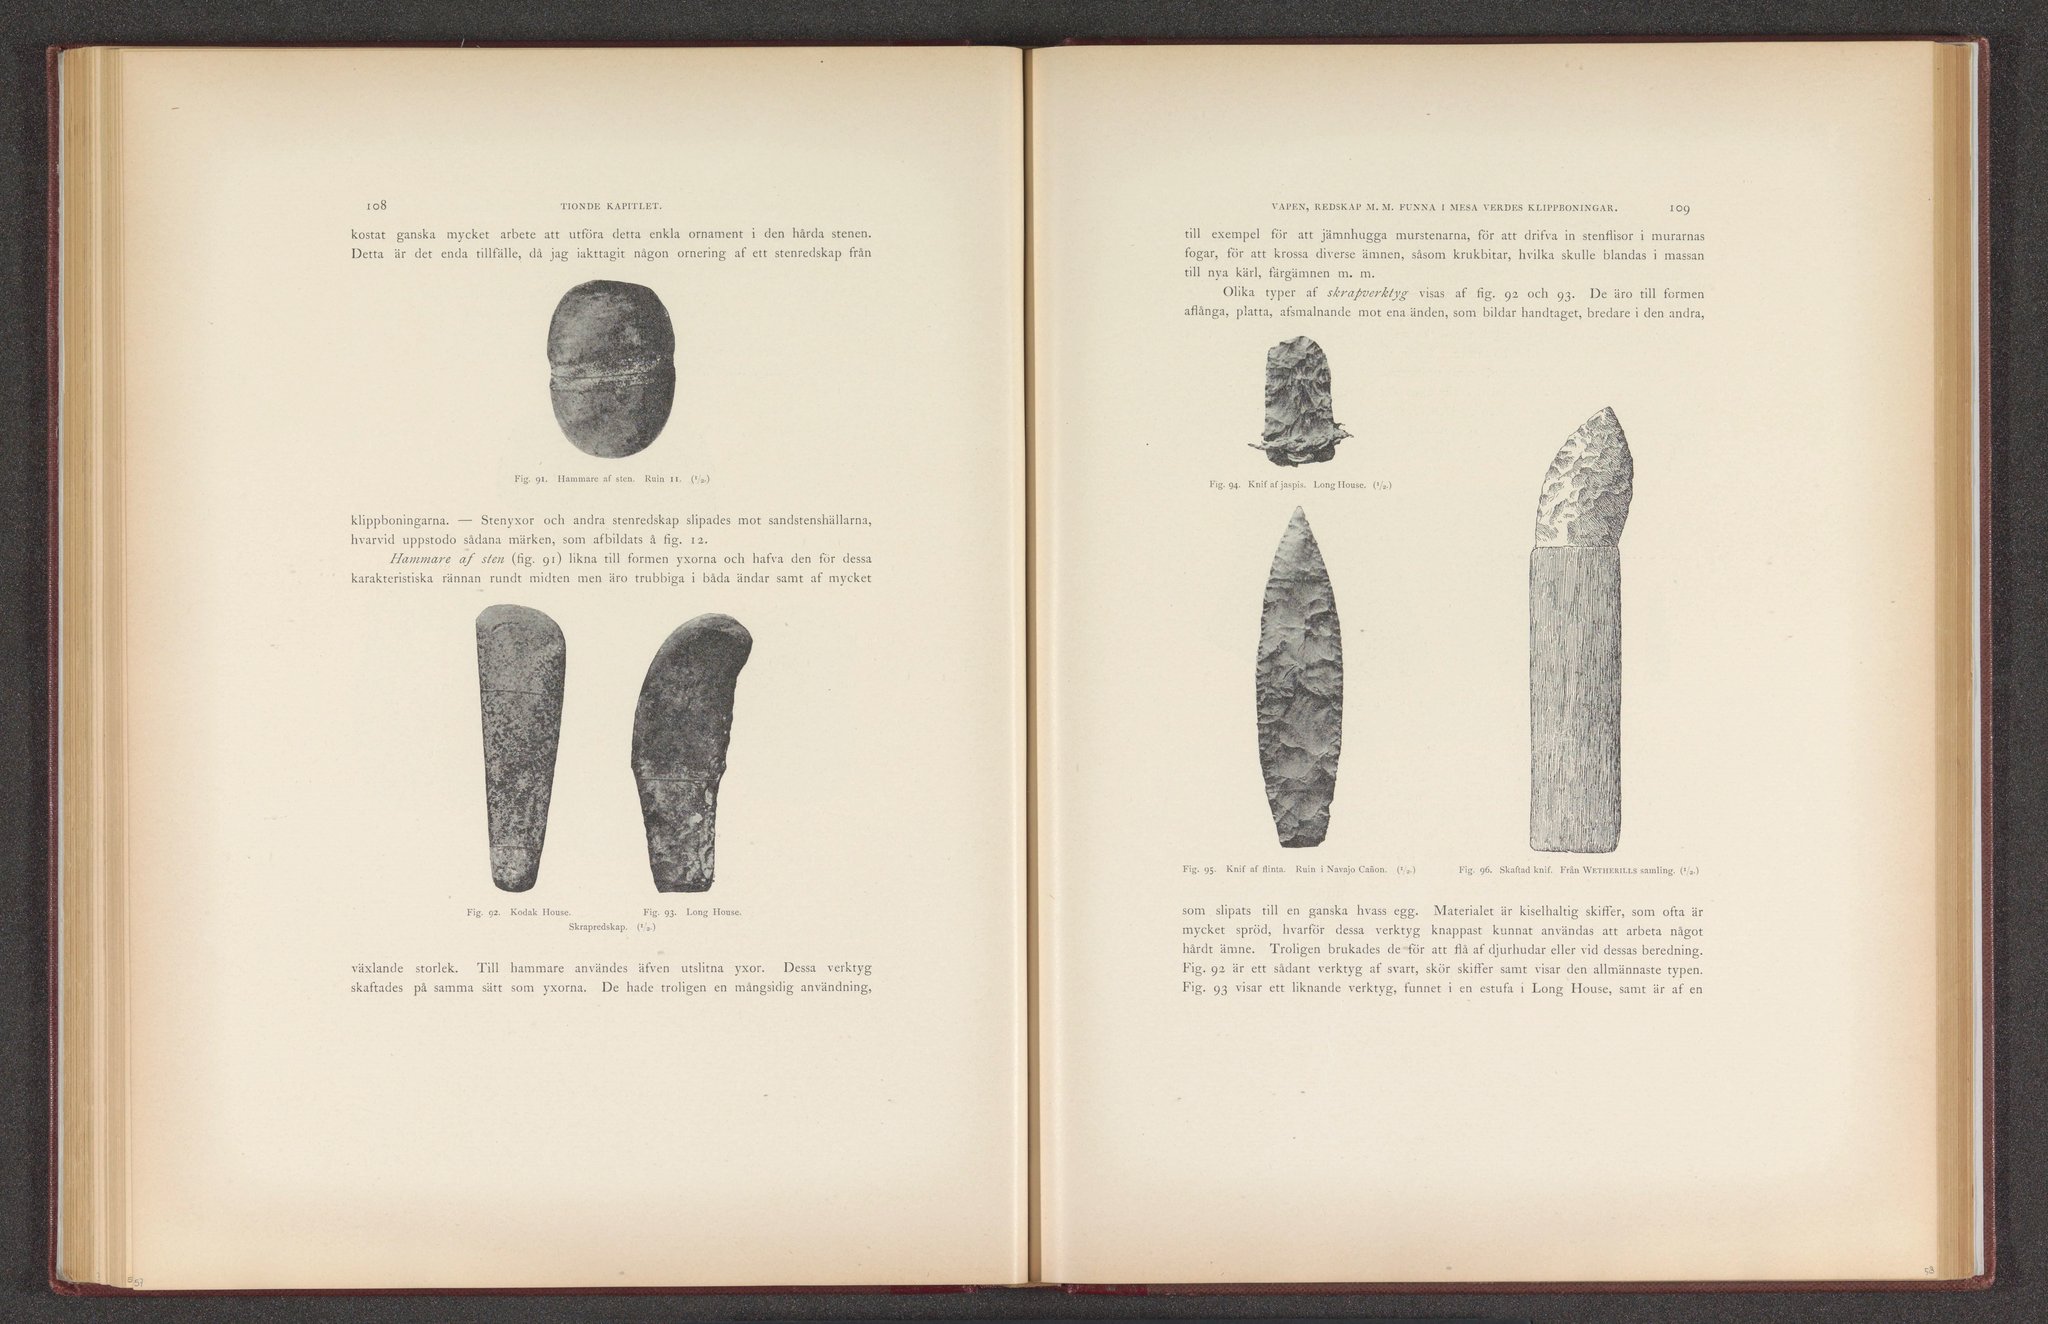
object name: photomechanical print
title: Hammare af sten (...) Skrapredskap (...)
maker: gustaf nordenskiöld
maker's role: fotograaf, schrijver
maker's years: 1868-1895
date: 1891-1893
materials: paper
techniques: autotype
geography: vienna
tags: tools, aids, implements ~ crafts and industries: hammer, agricultural implements: spade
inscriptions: number: ‘Fig. 91. Fig. 92. Fig. 93.’